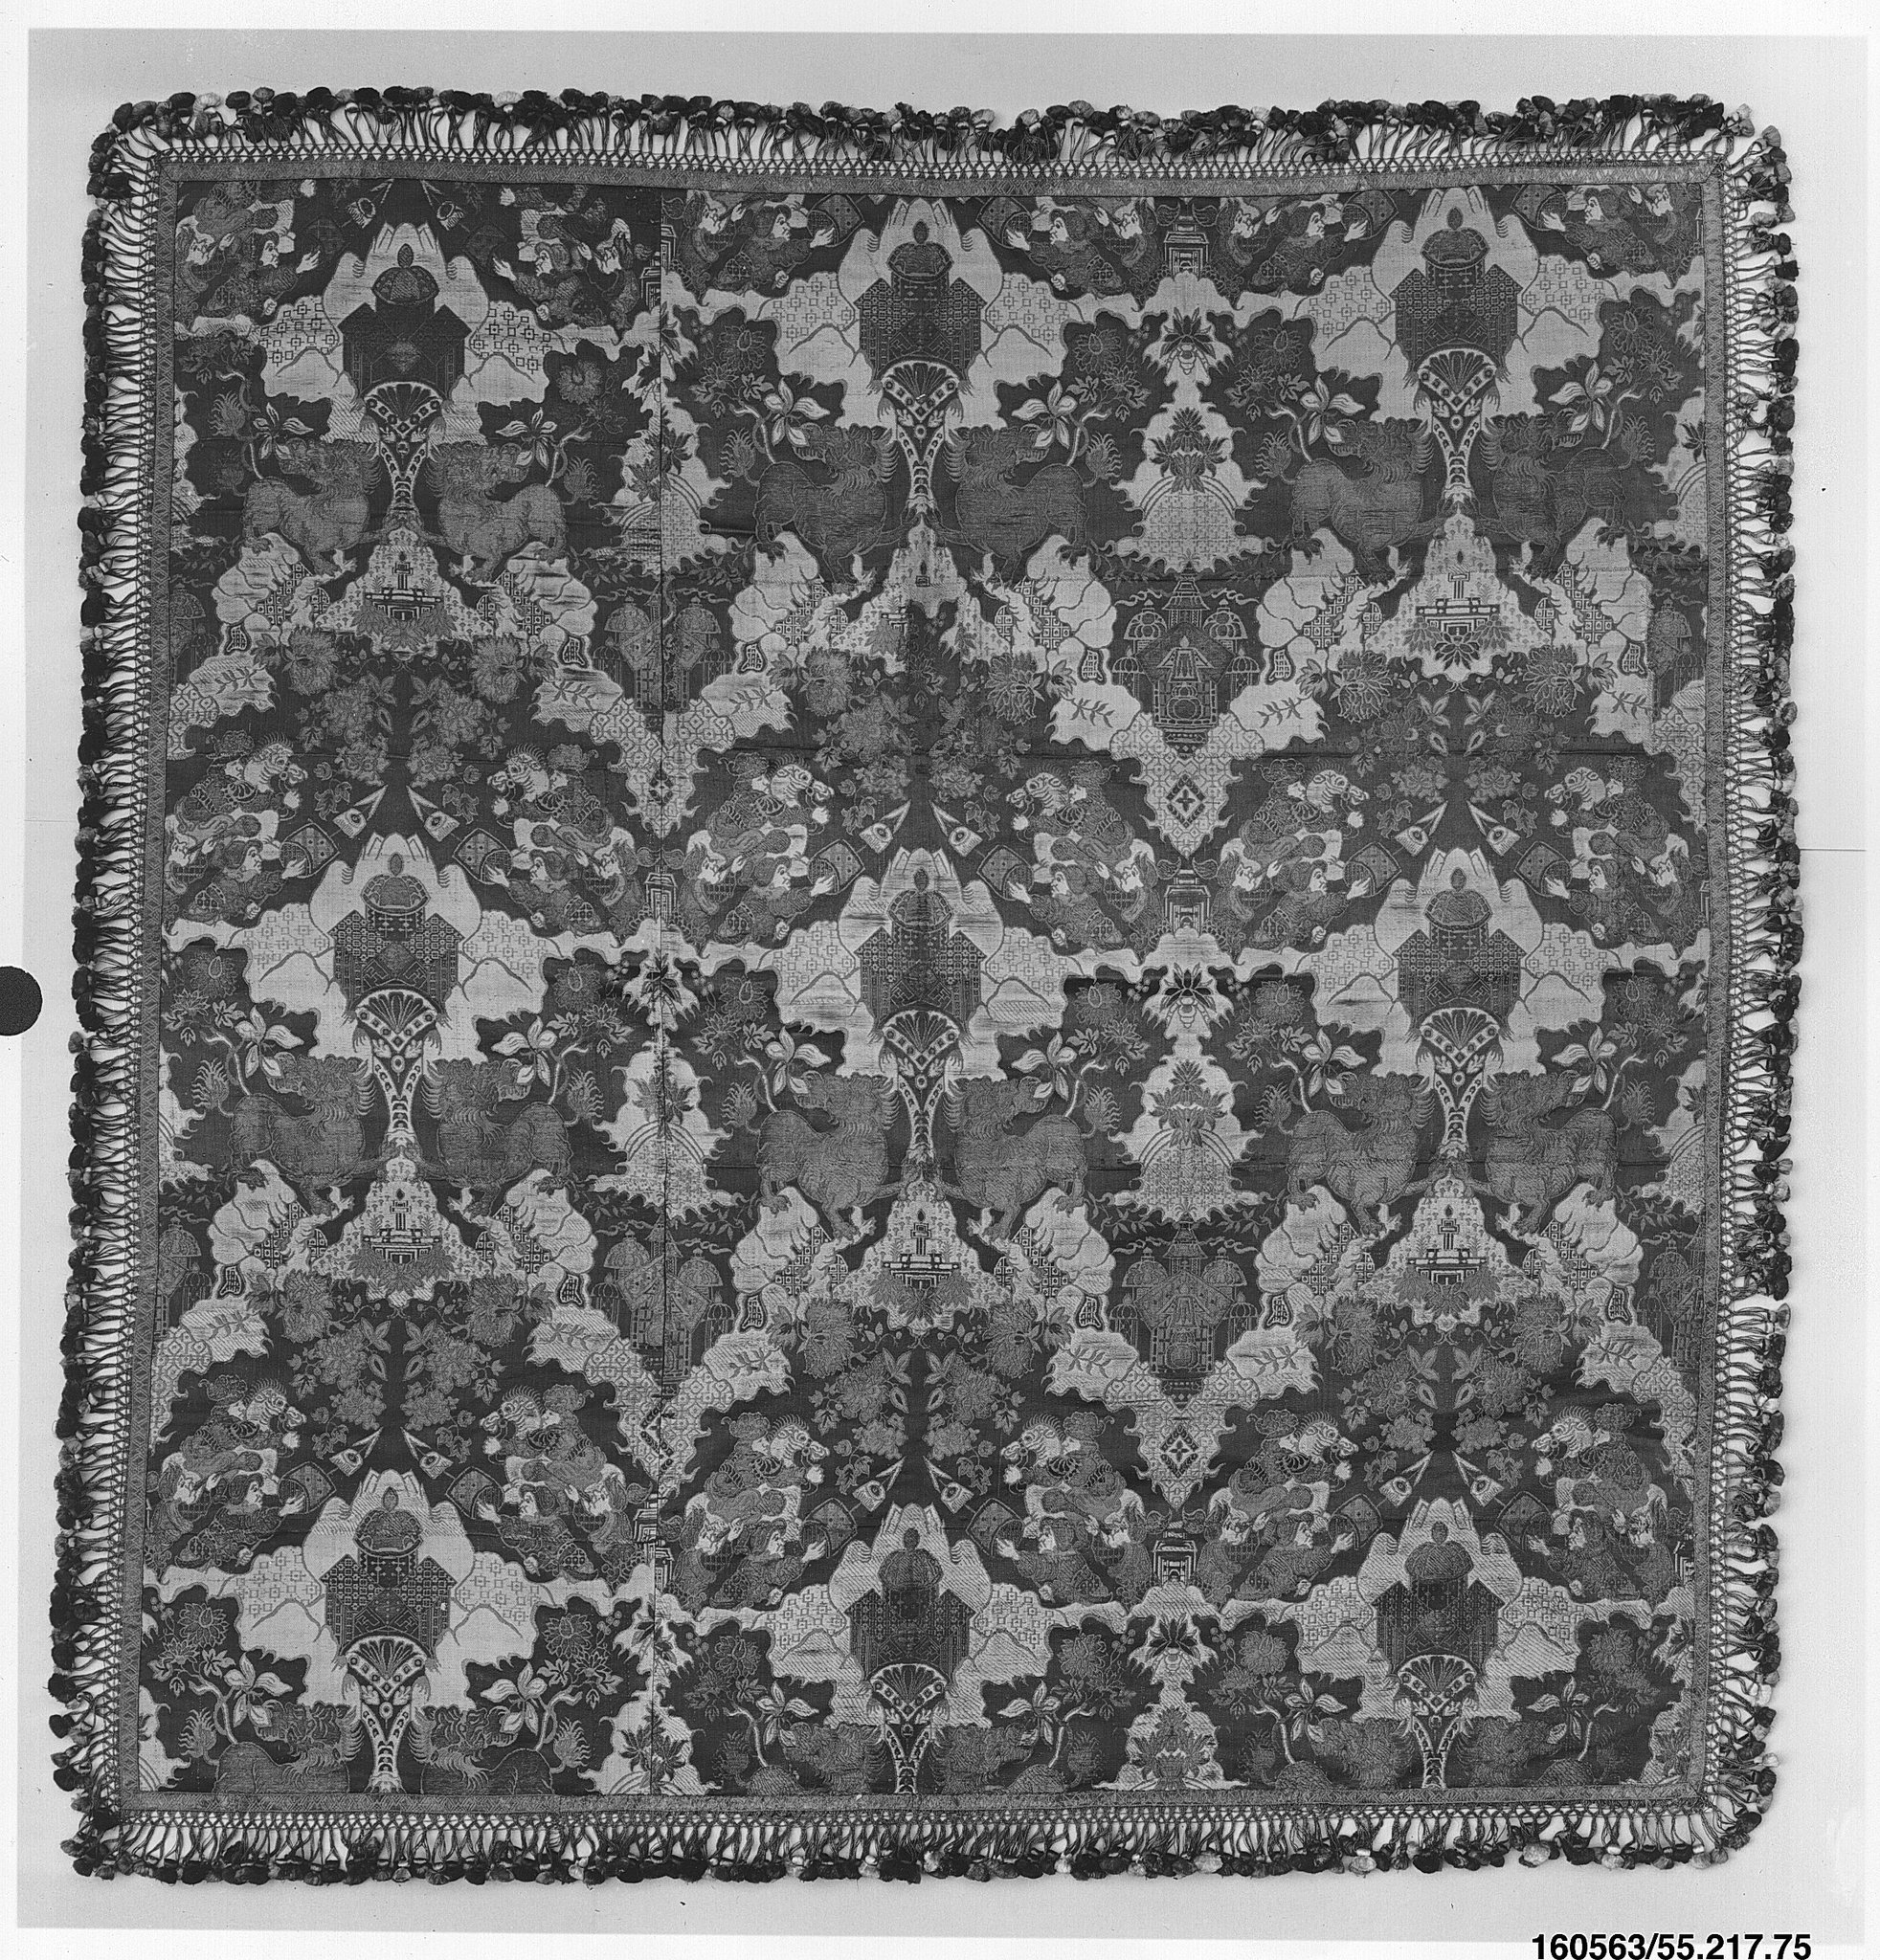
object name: cover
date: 1720-1730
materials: metal thread, silk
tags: flowers